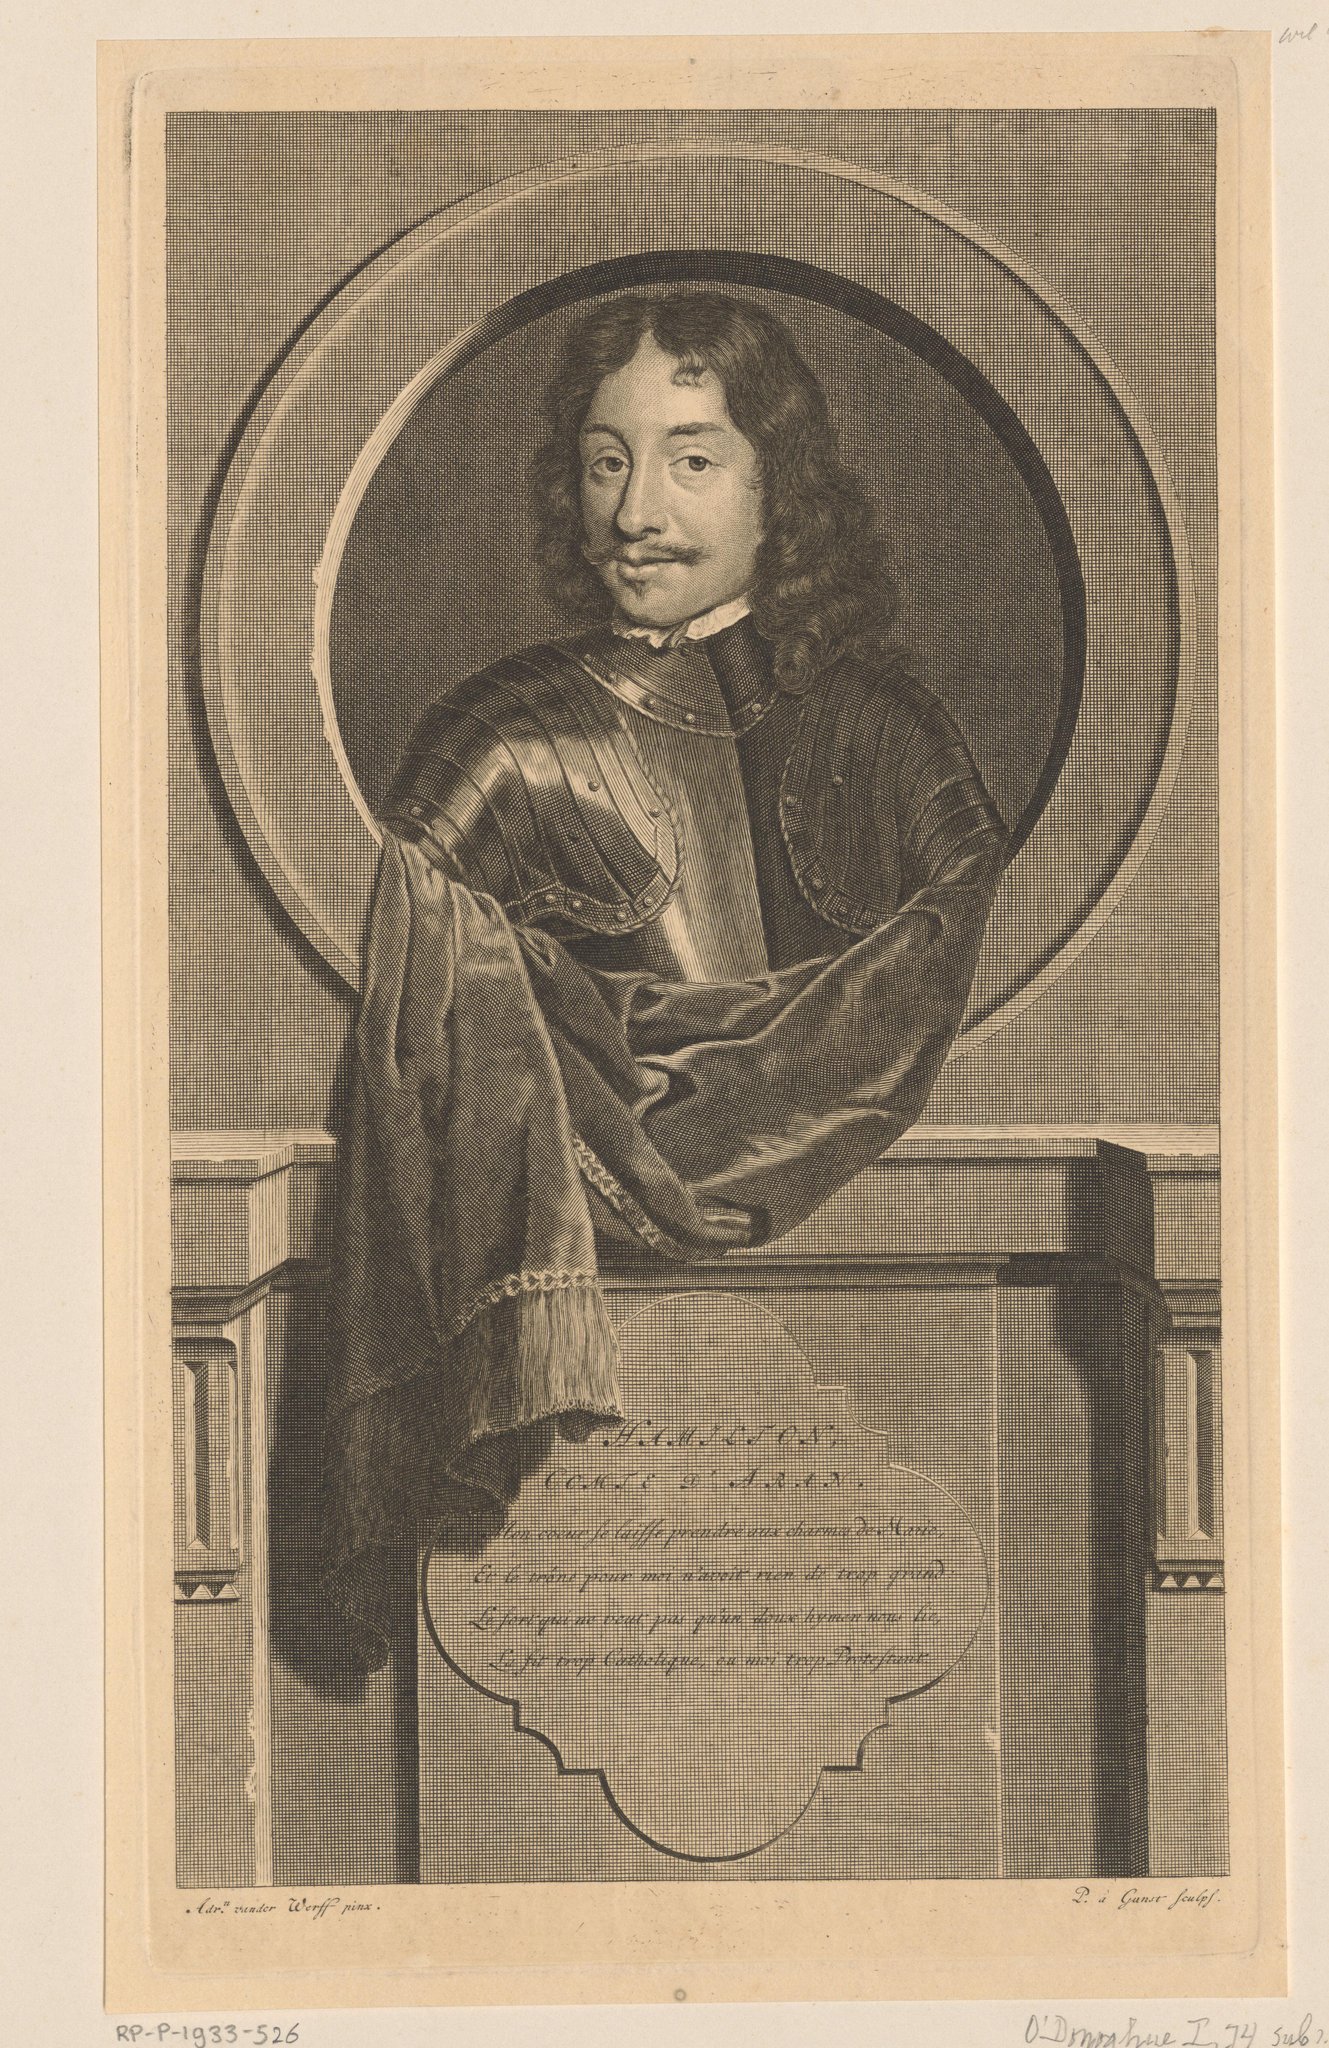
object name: print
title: Portret van James Hamilton, graaf van Arran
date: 1723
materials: paper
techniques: engraving, etching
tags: armour, historical persons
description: Prent ook gebruikt in: Larrey, Isaac. Histoire d'Angleterre, d'Ecosse et d'Irlande. Amsterdam: Covens & Mortier, 1723, dl. 3.